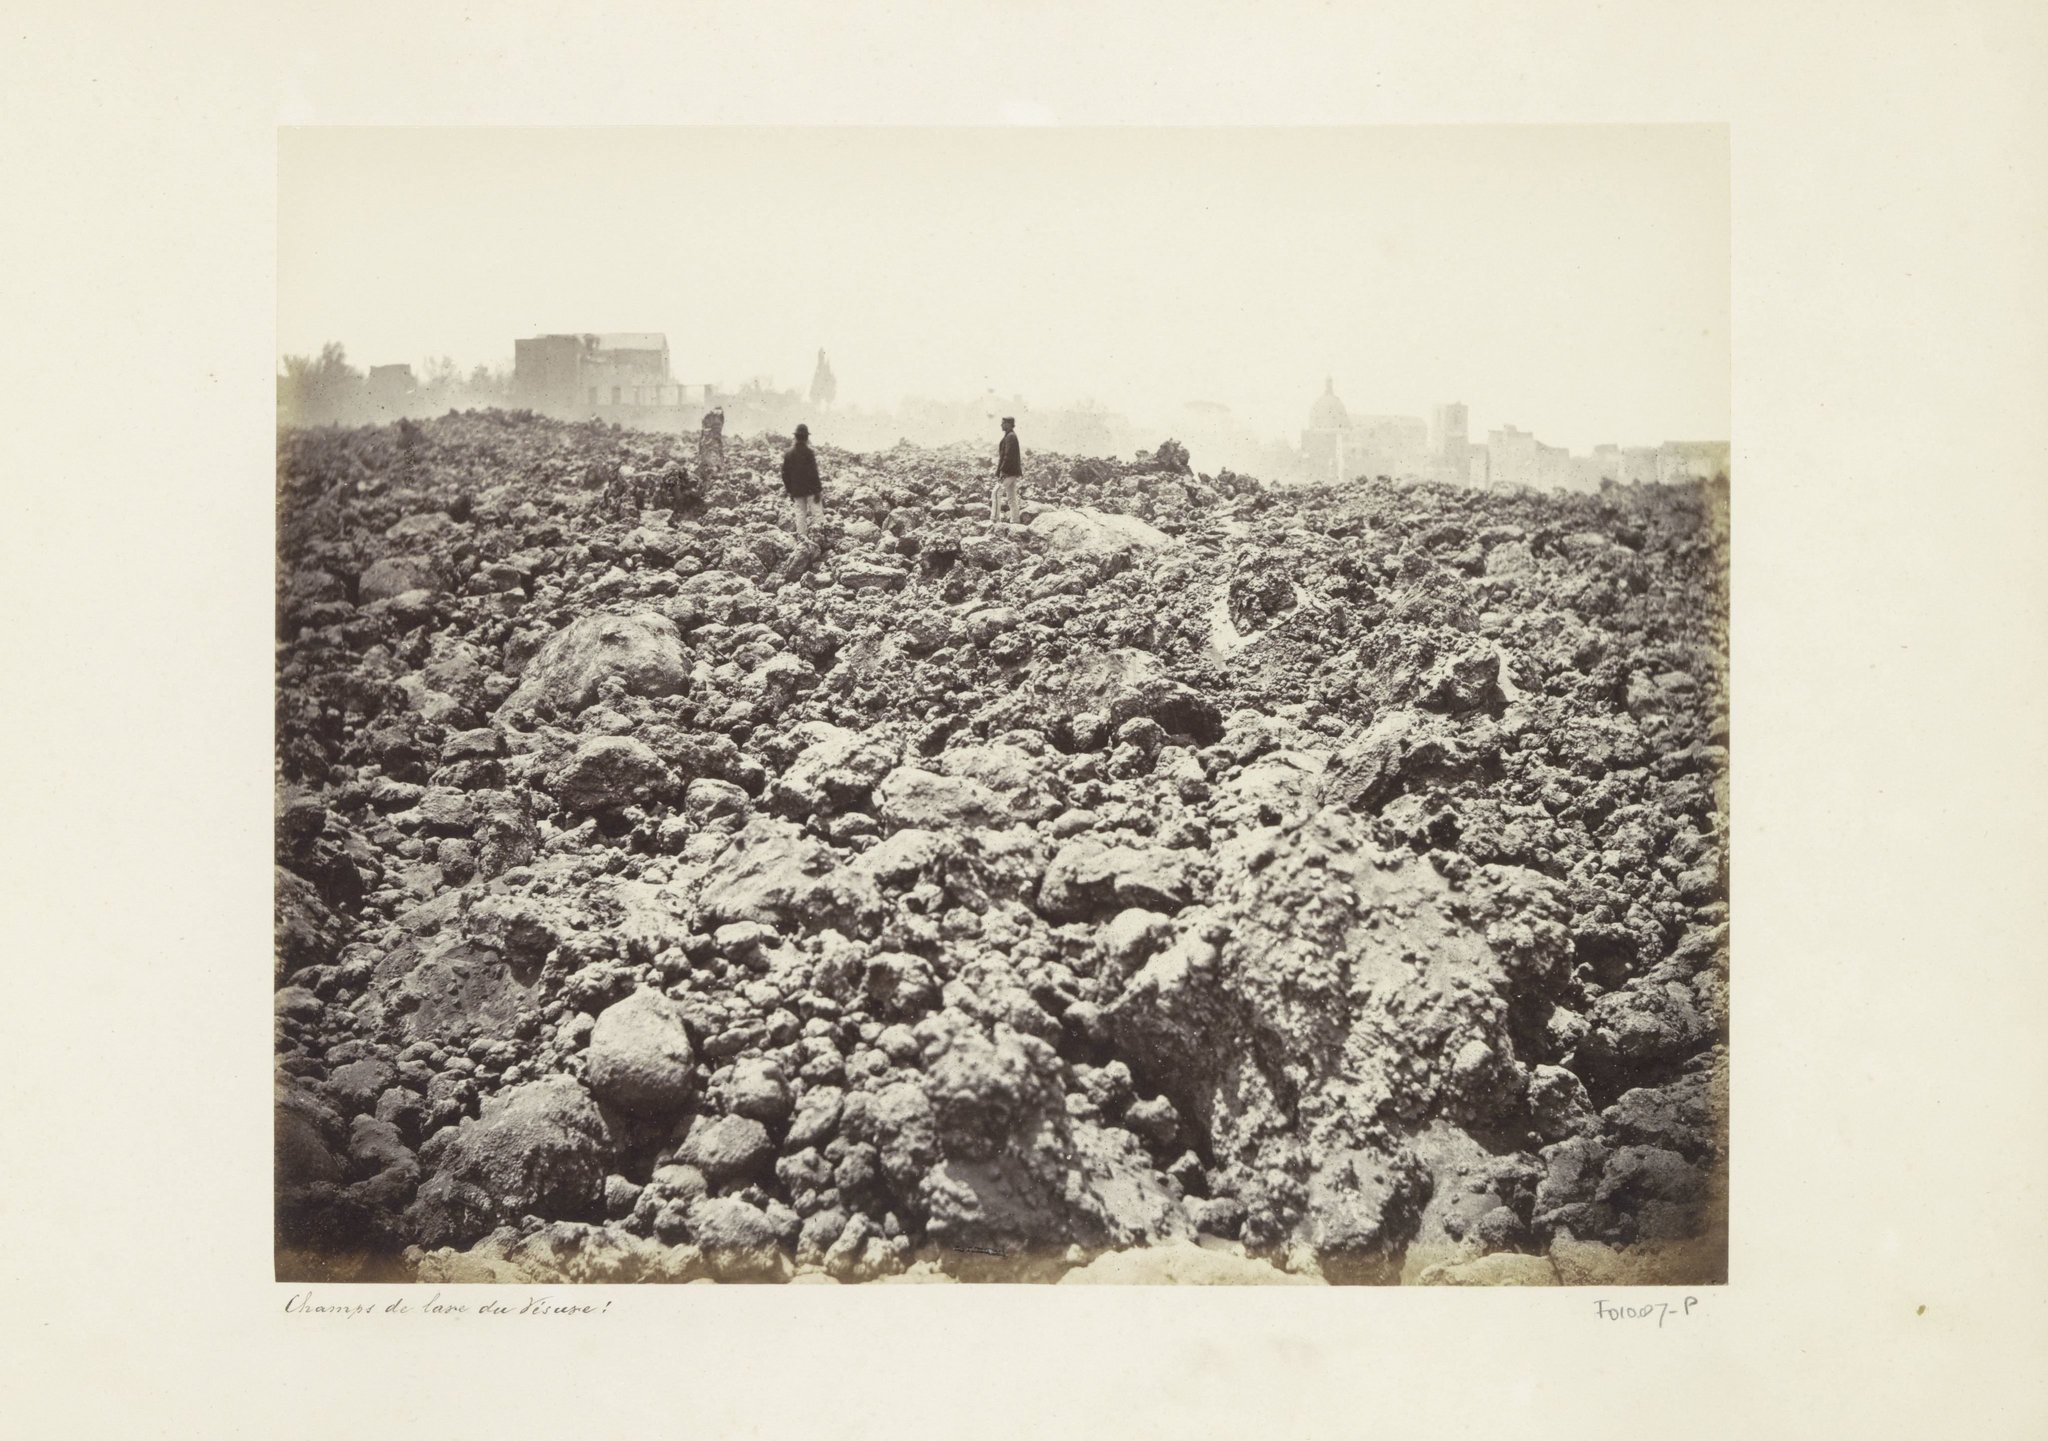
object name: photograph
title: Champs de lave du Vésuve!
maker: Anonymous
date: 1865-1875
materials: paper, photographic support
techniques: albumen print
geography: naples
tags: cold lava, naples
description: Onderdeel van Reisalbum met foto's van bezienswaardigheden in Napels en omgeving.